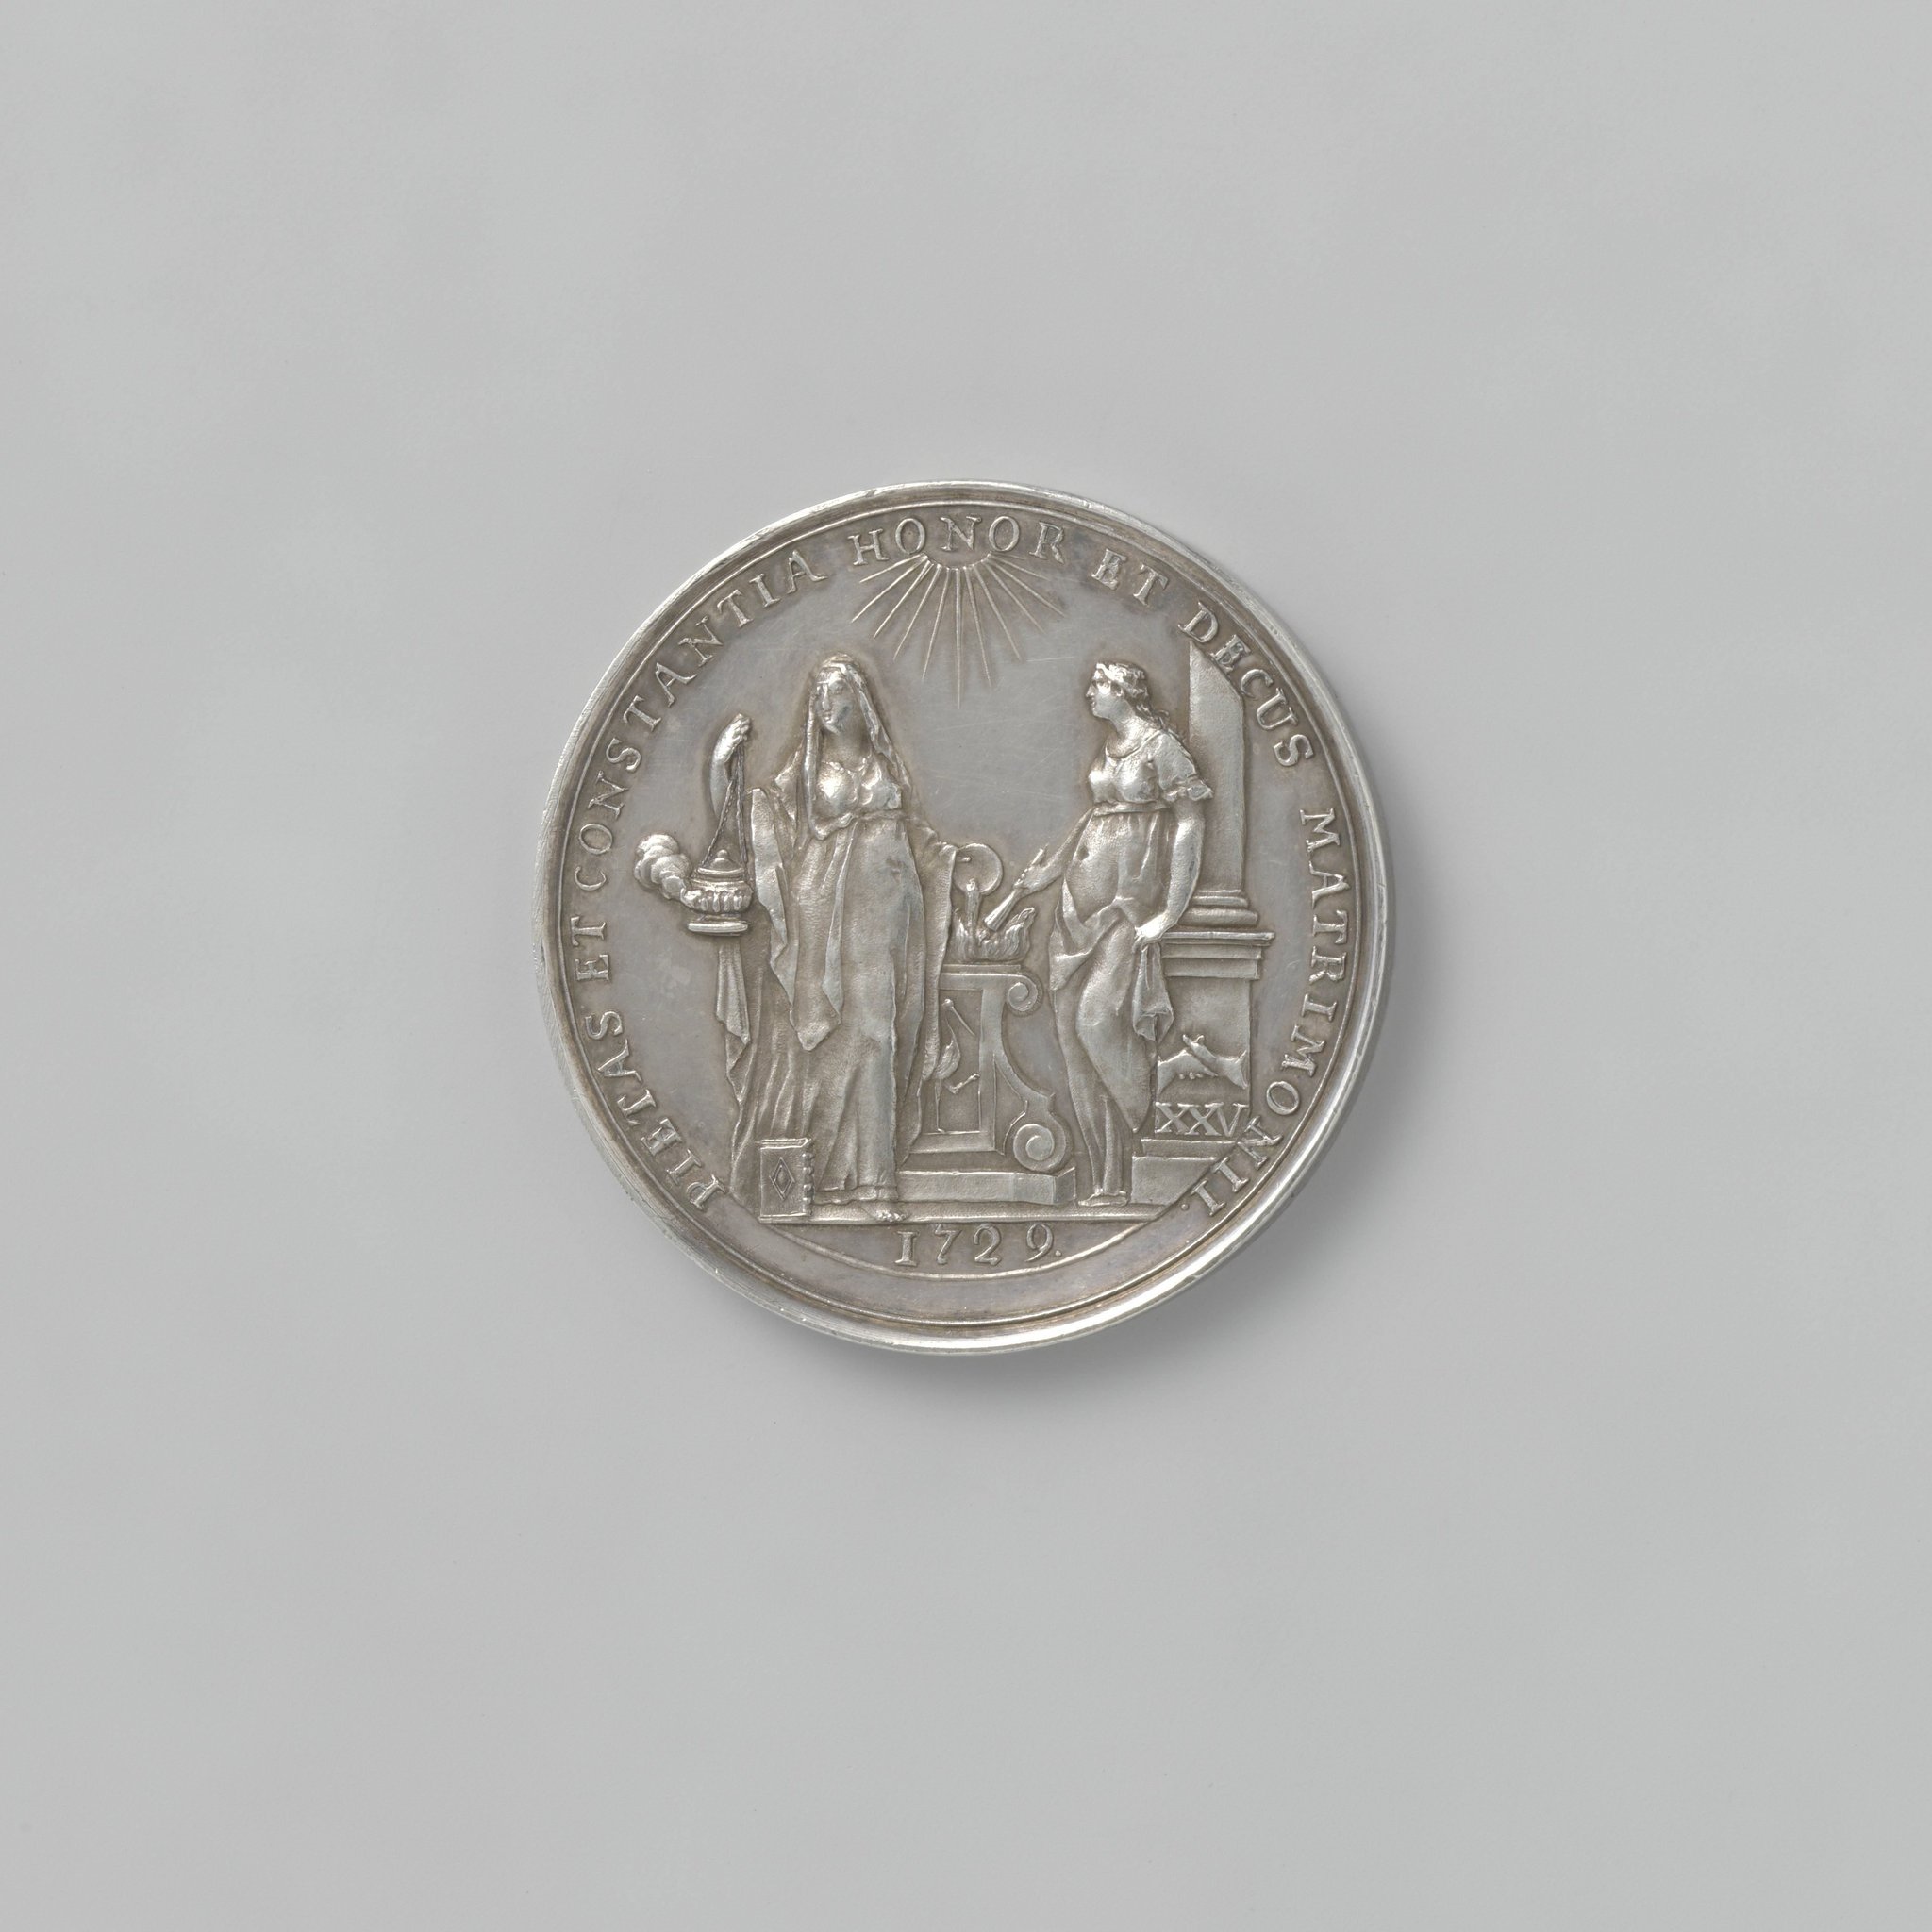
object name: marriage medal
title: Family medal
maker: willem de wijs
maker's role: medailleur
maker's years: 1700-1795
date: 1729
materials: silver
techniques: striking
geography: netherlands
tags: mayor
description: 25th Wedding Anniversary of Egidius van den Bempden & Aegje Hooft